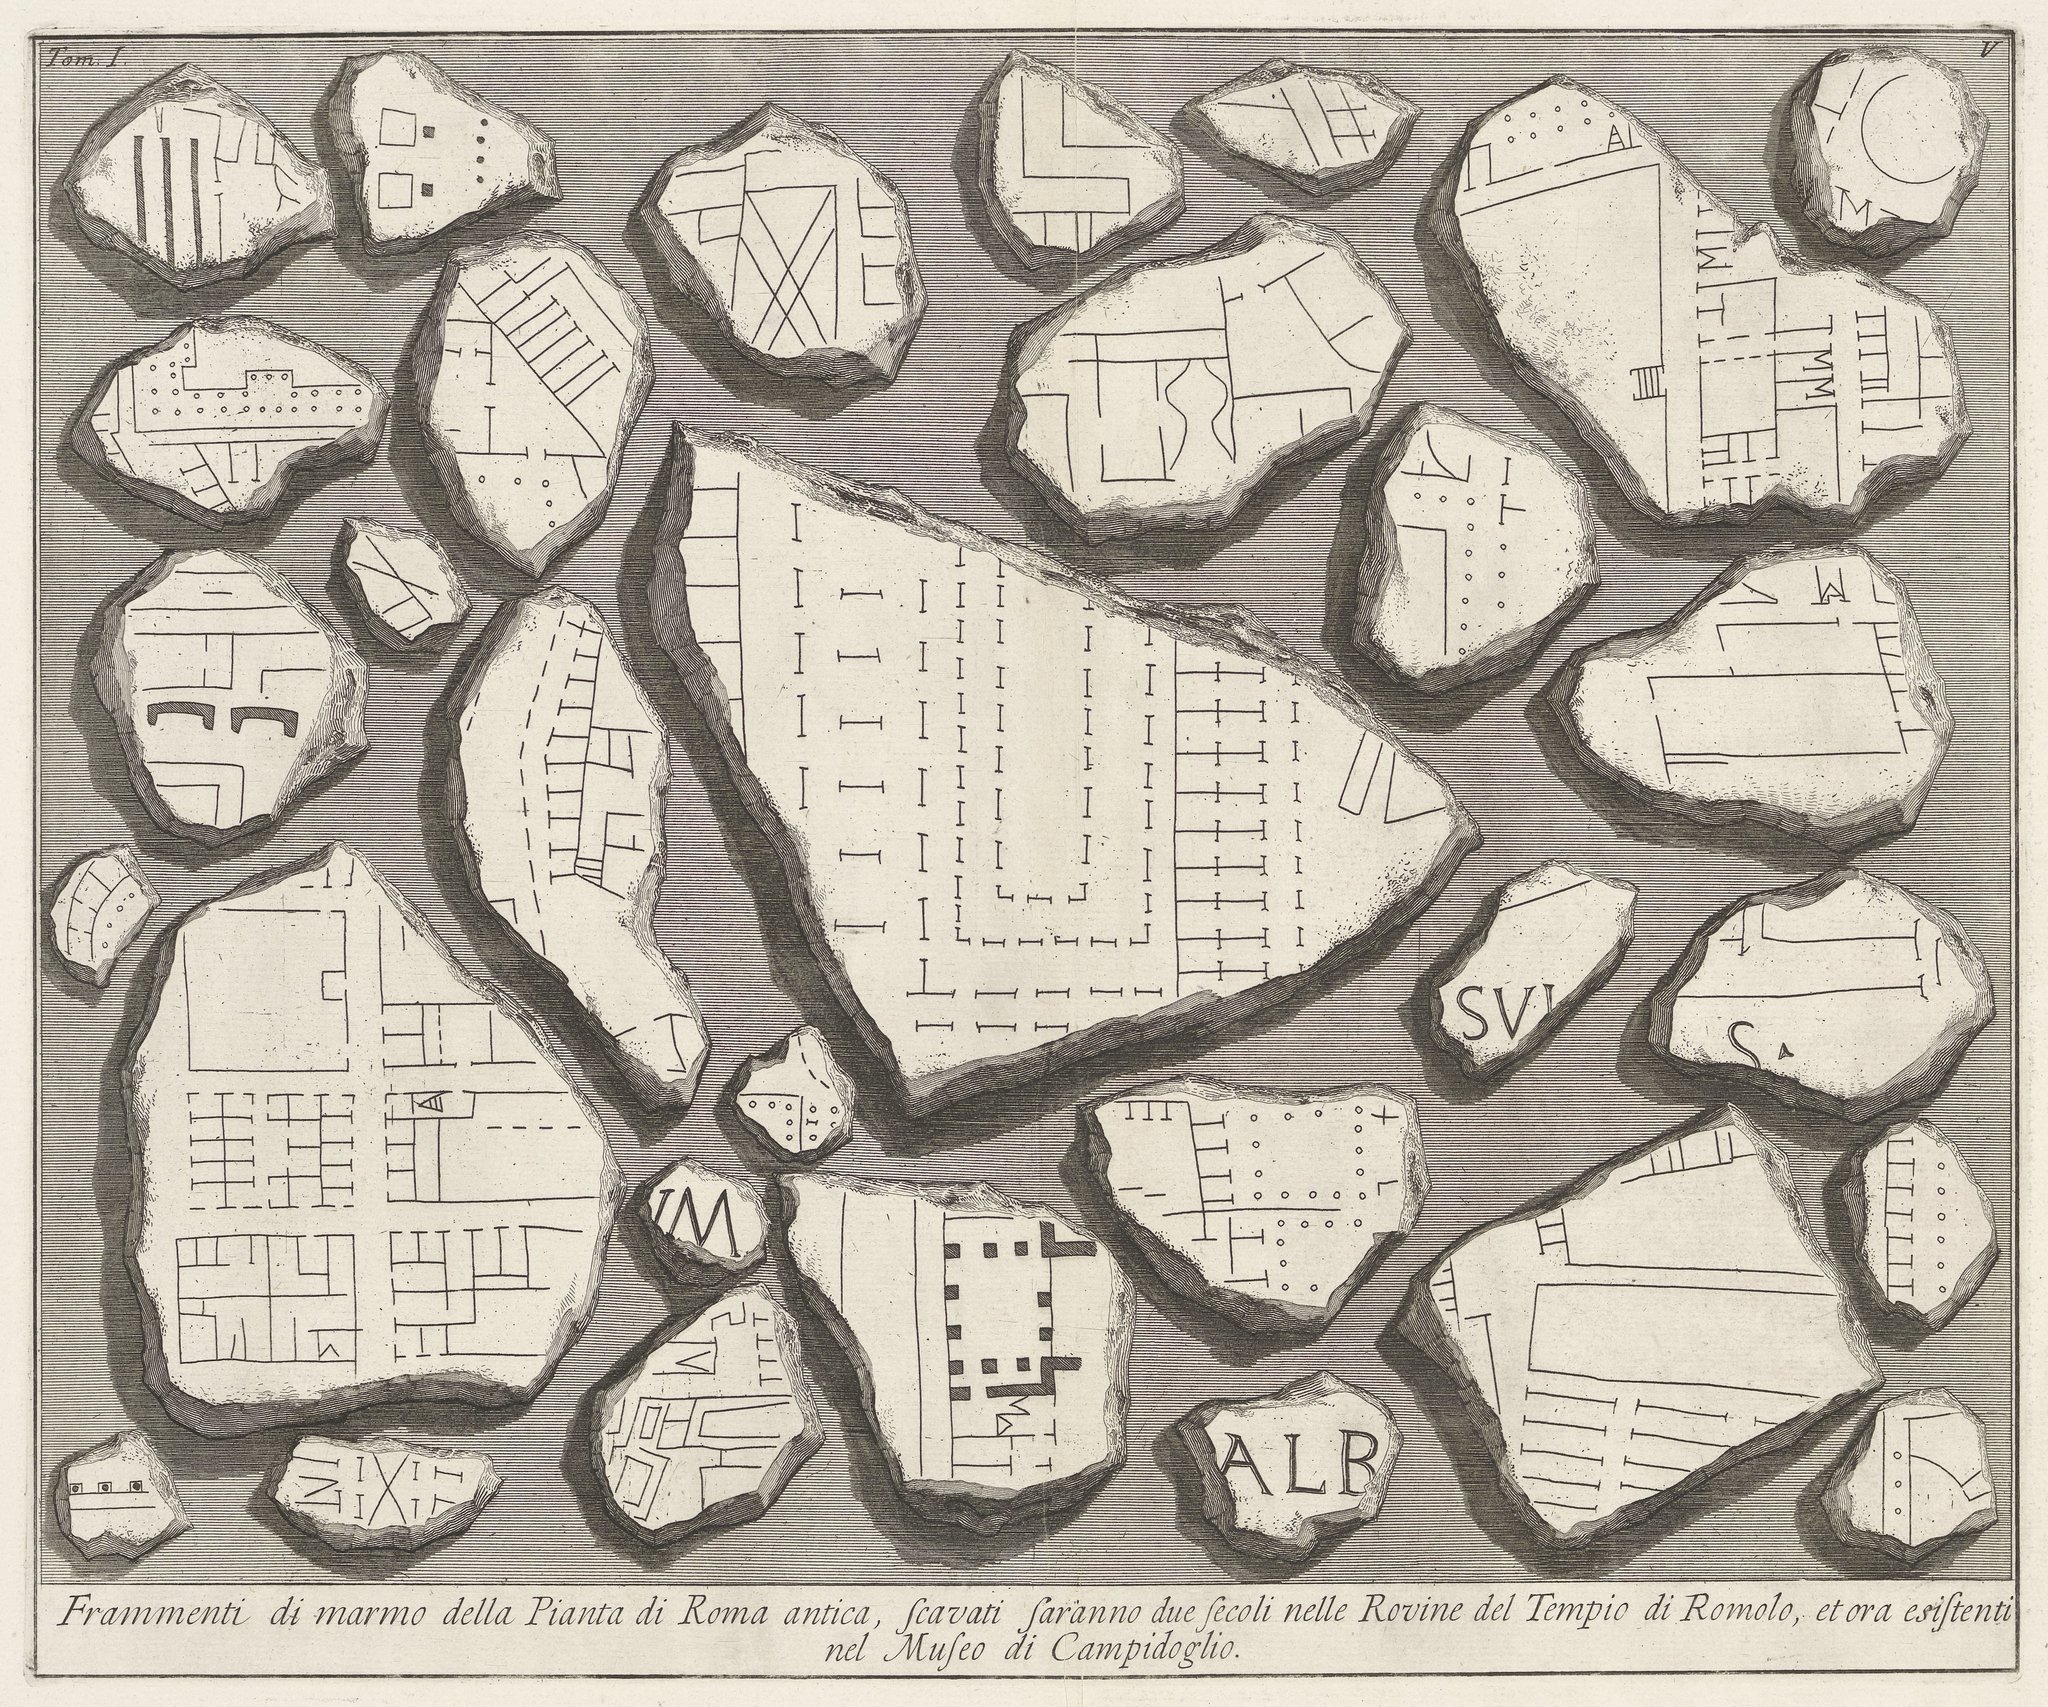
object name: print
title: Archeologische vondsten in en rond Rome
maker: giovanni battista piranesi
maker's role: designer, draughtsman, print maker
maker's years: 1720-1778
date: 1756-1757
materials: paper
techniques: etching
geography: rome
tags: maps, atlases, rome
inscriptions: collector's mark: Lugt 2228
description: Deze prent maakt deel uit van de serie 'Le Antichità Romane'. Piranesi deed meer dan acht jaar voorstudie voor deze 250 platen tellende serie die in vier volumes werd uitgegeven. Hij produceerde de prenten tussen ca. 1756 en 1757. De serie bevat ook prenten door of naar andere prentmakers, onder wie Francesco Bianchini en Girolamo Rossi.